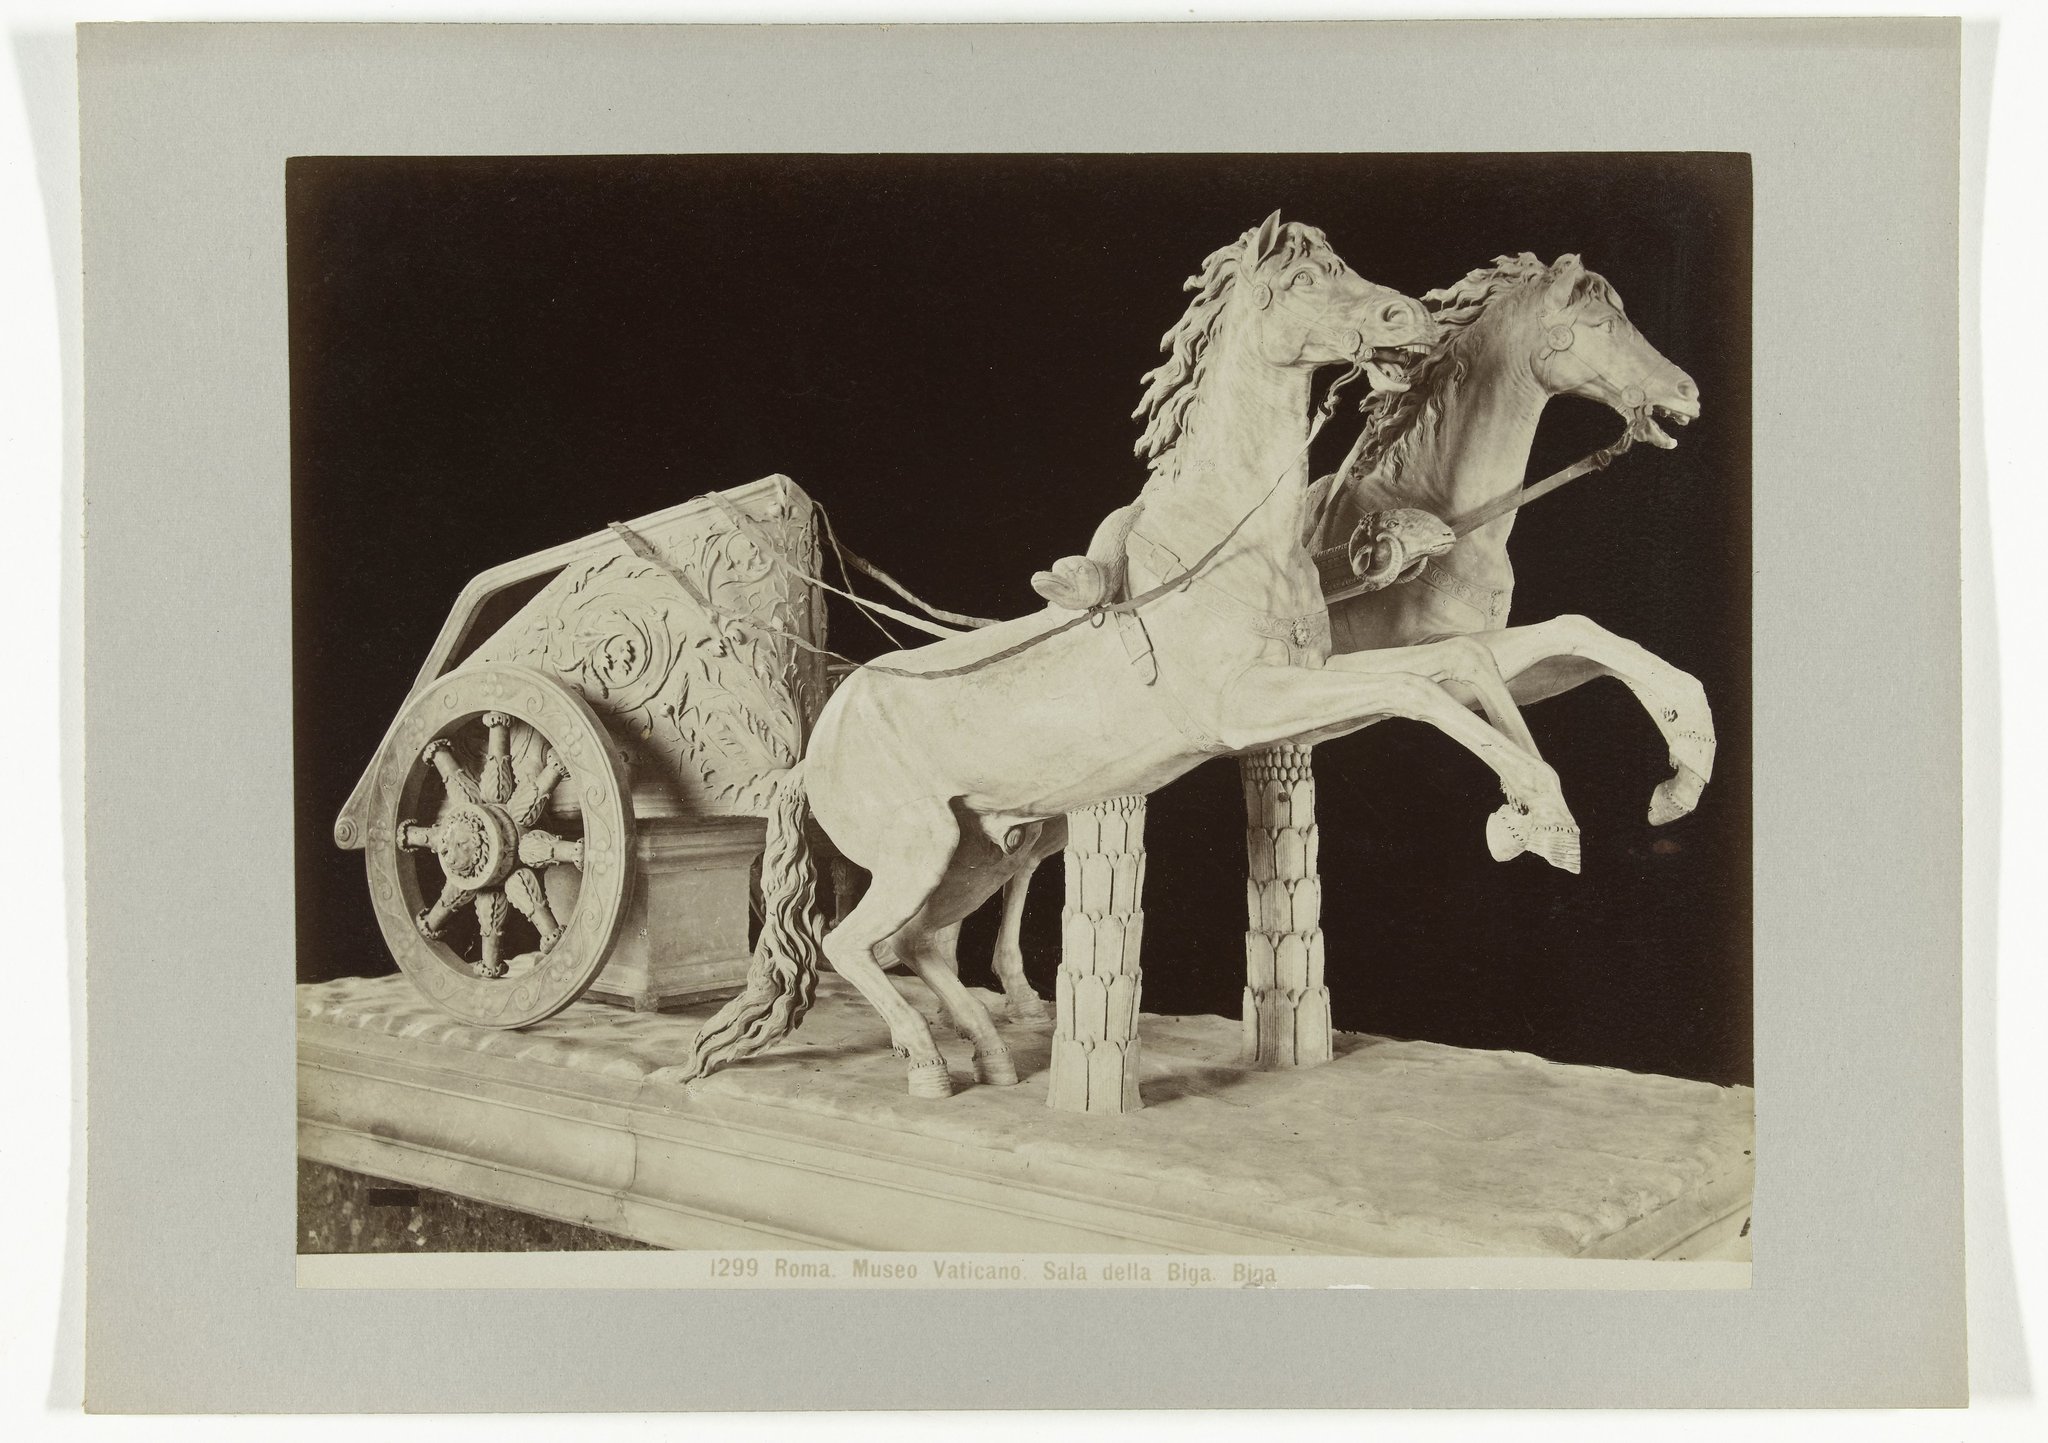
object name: photograph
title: Sculptuur van strijdwagen getrokken door twee paarden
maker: Anonymous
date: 1880-1904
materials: cardboard, paper, photographic support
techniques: albumen print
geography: rome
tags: vaticaanse musea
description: Linksonder is met zwarte inkt een rechthoekig vakje getekend, mogelijk over een geschreven nummer heen.